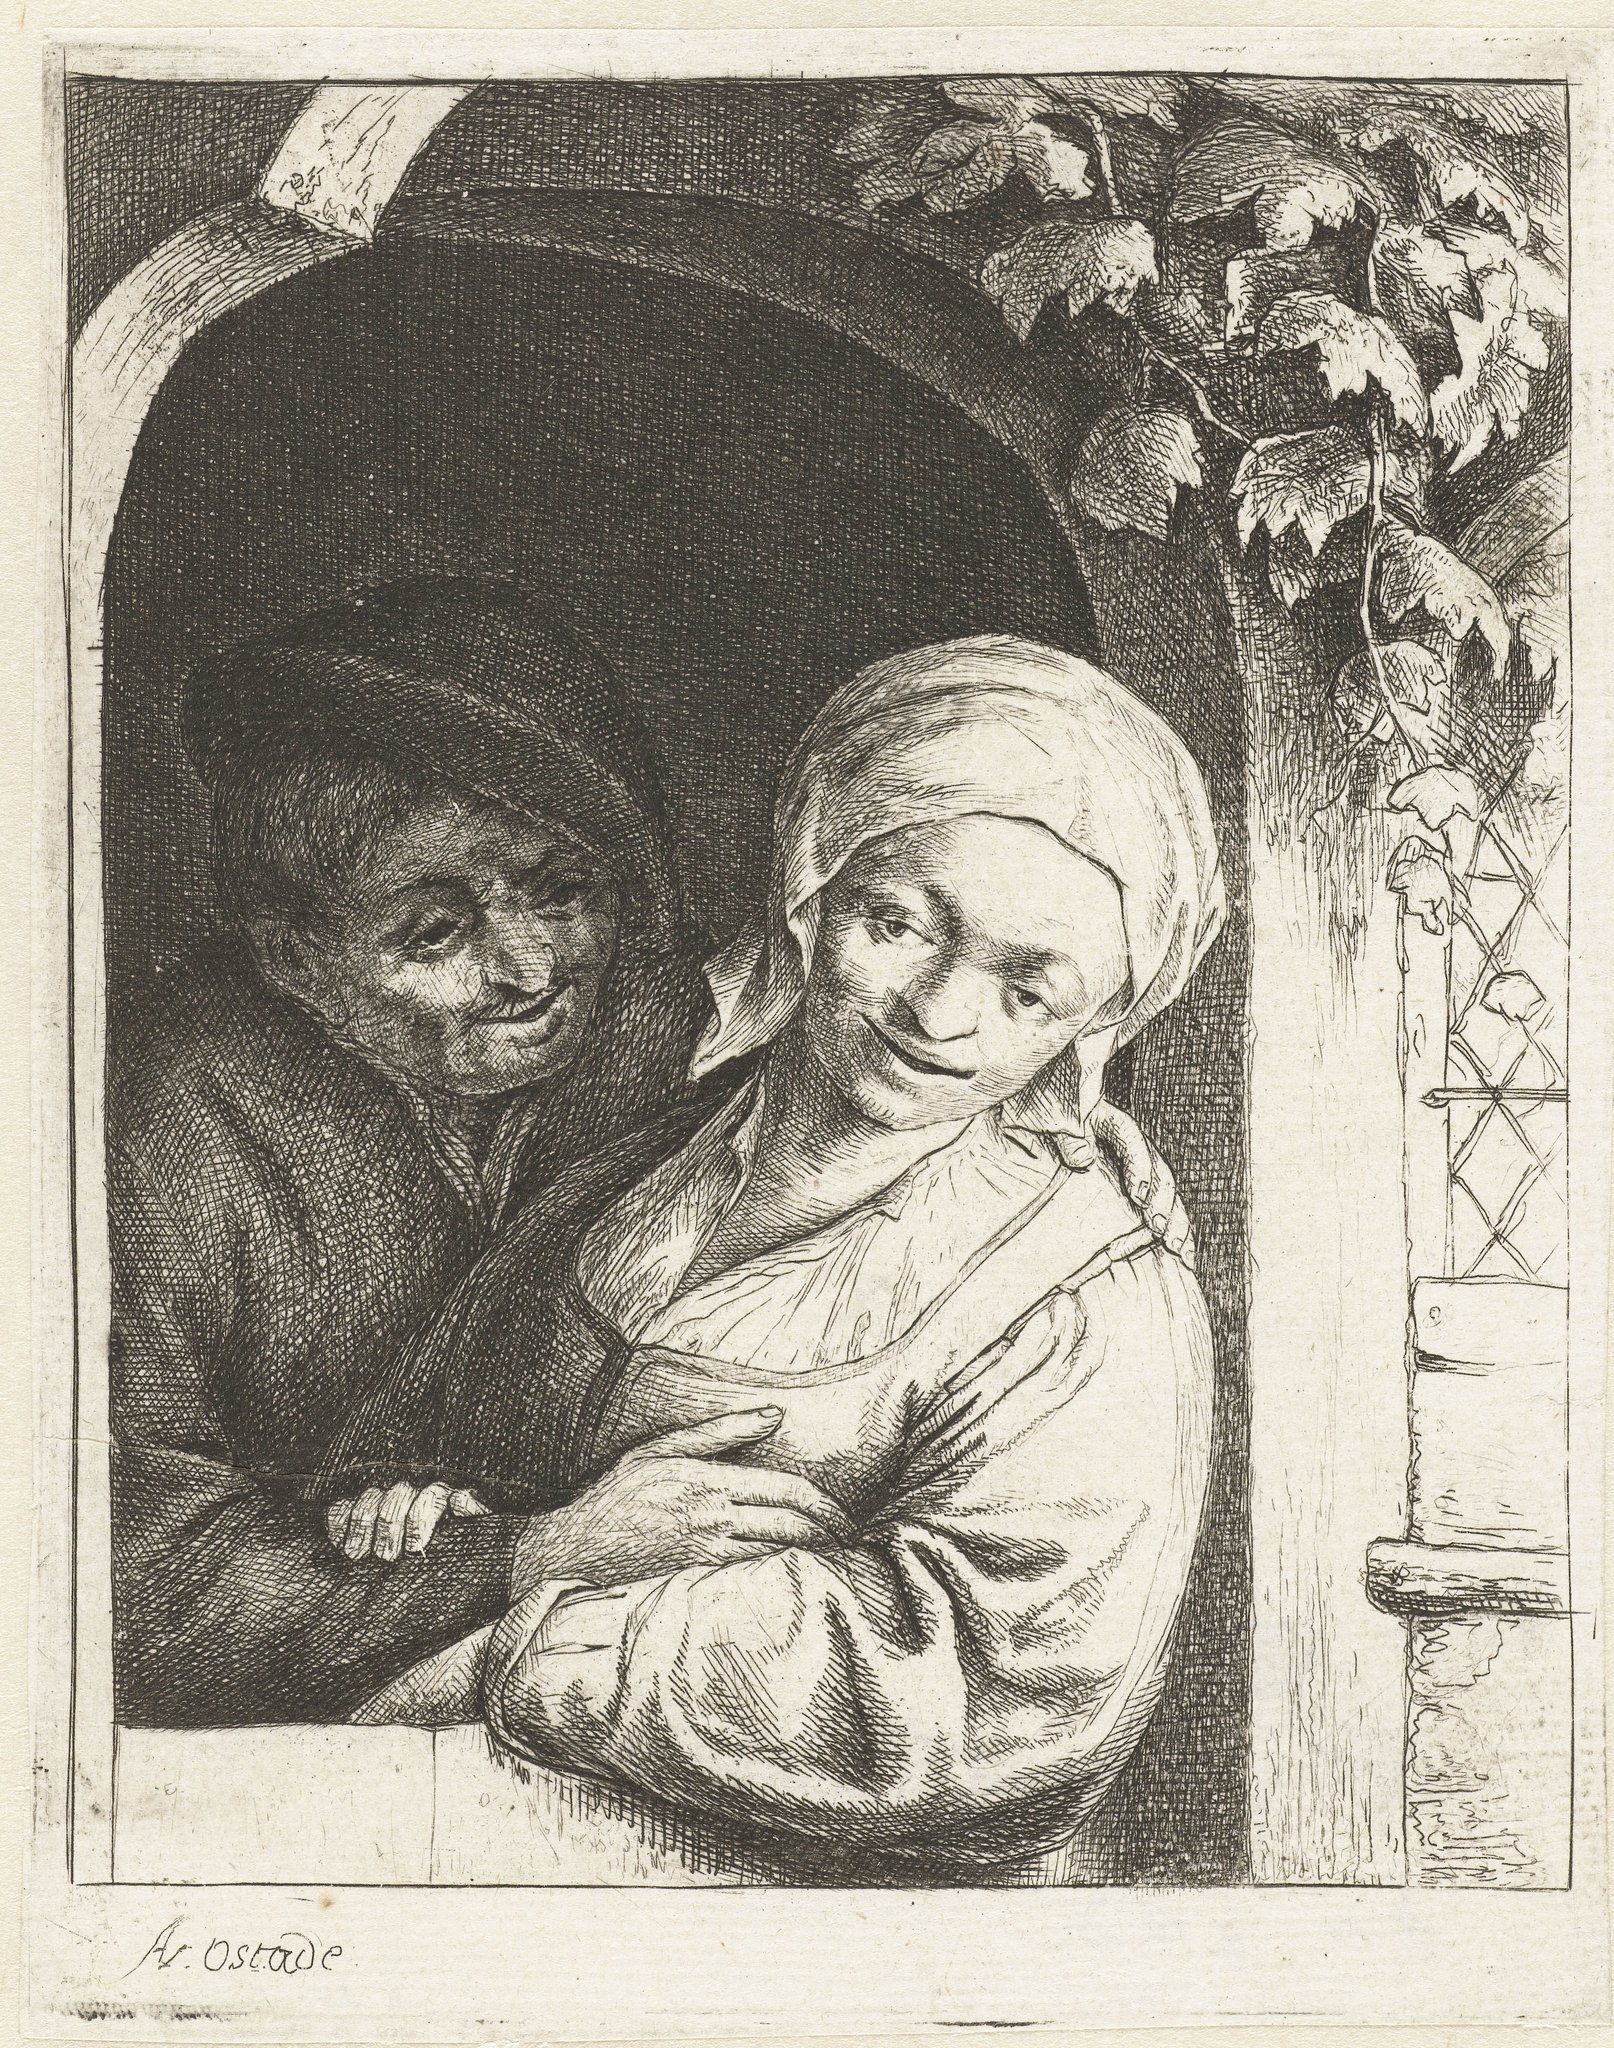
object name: print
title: Boeren vrijage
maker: adriaen van ostade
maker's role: draughtsman, painter, print maker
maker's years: 1610-1685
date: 1650-1654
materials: paper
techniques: drypoint, etching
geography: haarlem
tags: couple of lovers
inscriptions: collector's mark: Lugt 2610, collector's mark: Lugt 2228a